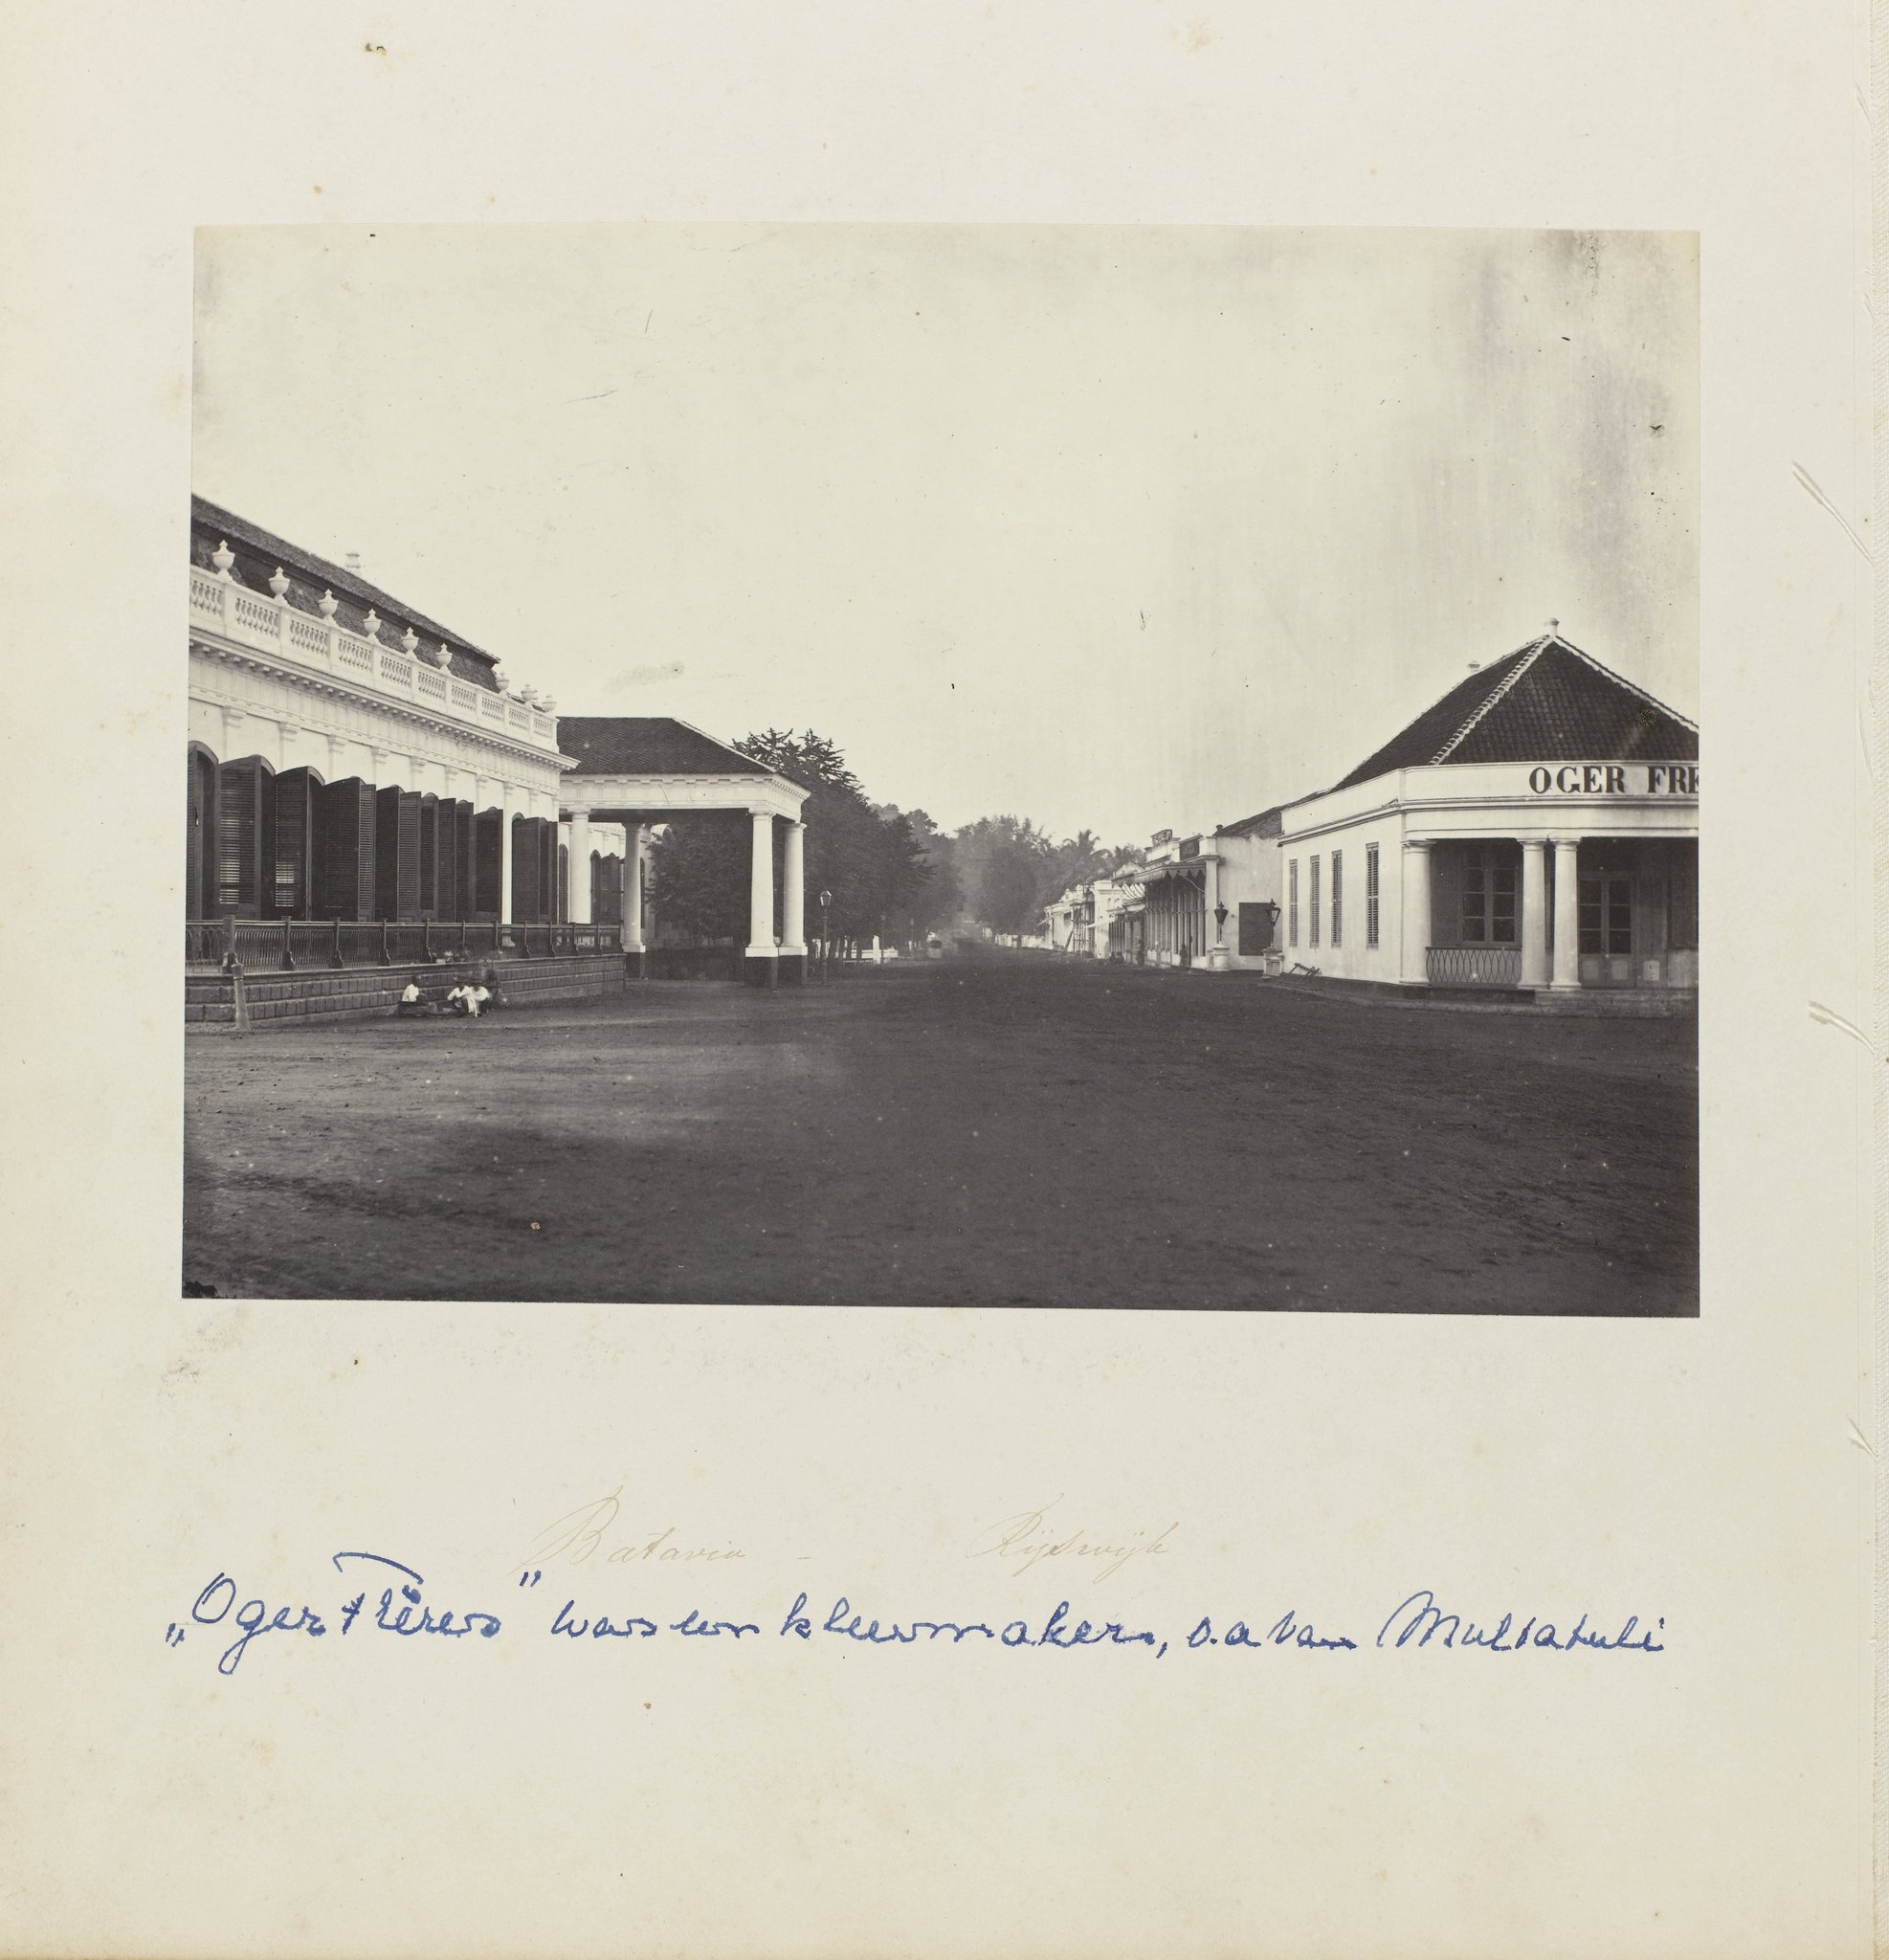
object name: photograph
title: Batavia - Rijswijk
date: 1863-1866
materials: photographic support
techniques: albumen print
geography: batavia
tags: street, batavia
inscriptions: inscription: ‘"Oger Frères" was een kleermaker, o.a. van Multatuli’, inscription: ‘Batavia - Rijswijk’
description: Winkels in de wijk Rijswijk in Batavia met rechts de kledingwinkel van de Oger Frères. Onderdeel van het rode fotoalbum met foto's van Java, uit het bezit van apotheker Specht-Grijp, die in 1865 vanuit Batavia naar Nederland terugkeerde.